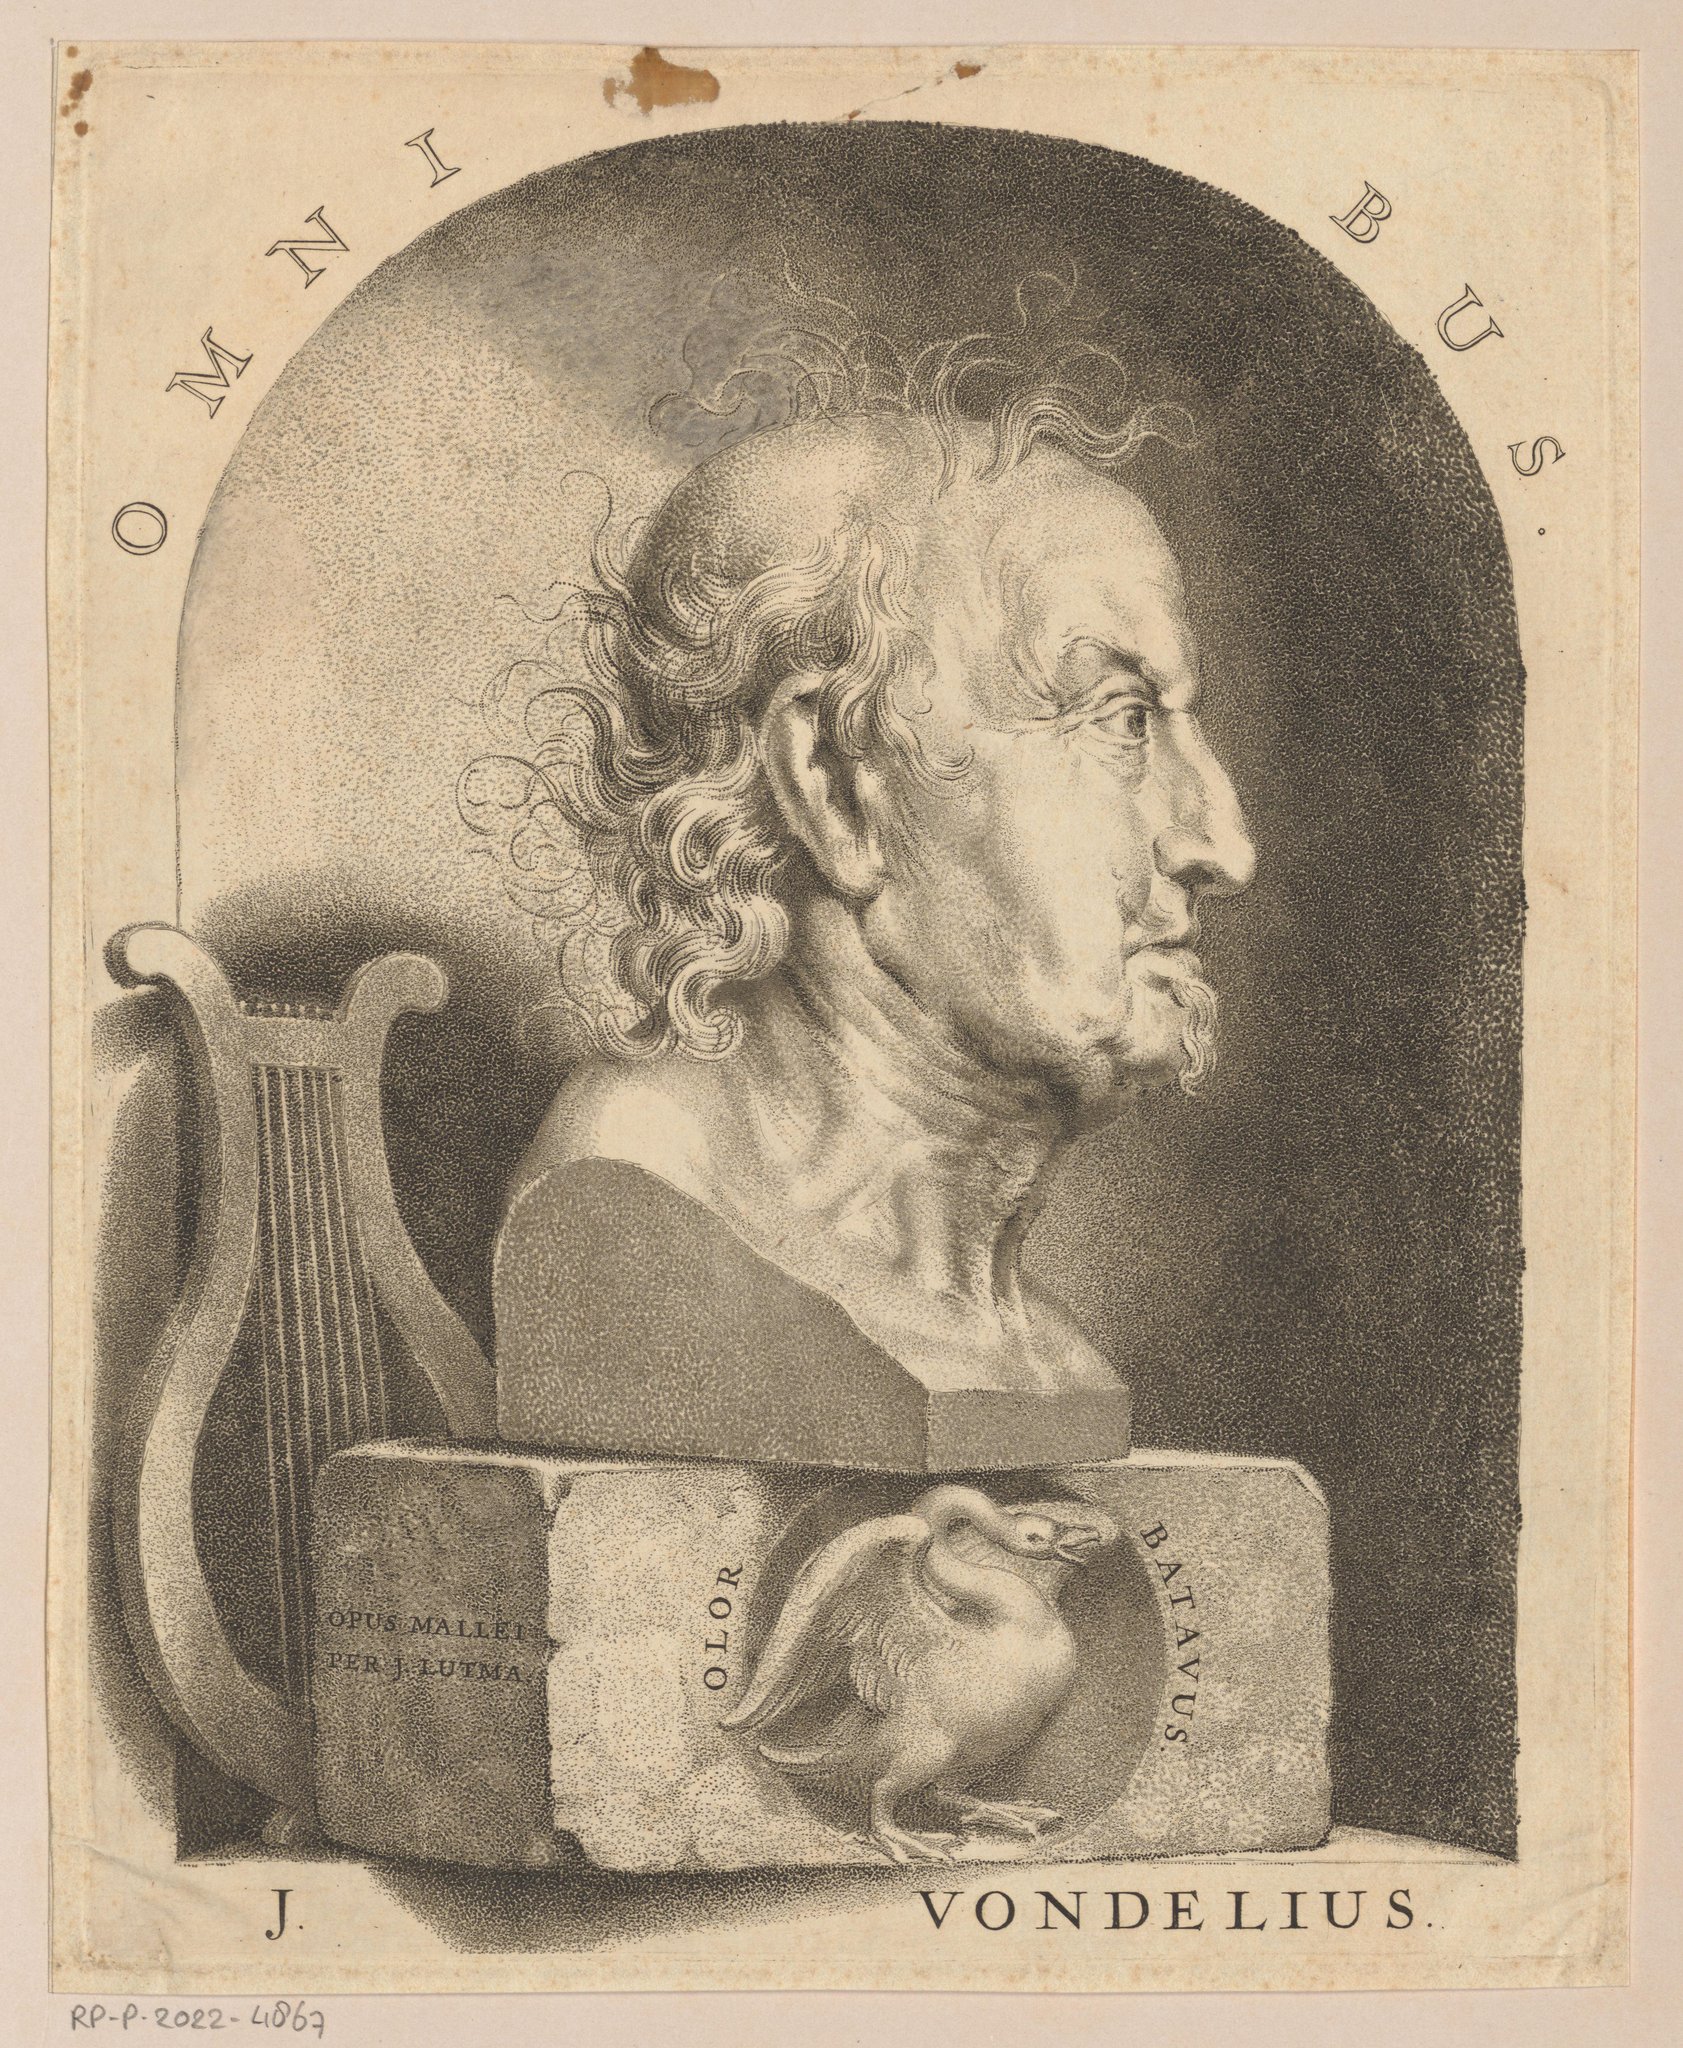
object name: print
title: Portret van Joost van den Vondel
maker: johannes lutma (1624-1689)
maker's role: print maker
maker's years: 1624-1689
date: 1681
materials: paper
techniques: punched engraving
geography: amsterdam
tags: amsterdam, joost van den vondel, historical persons, portrait of a writer, writer, poet, author, water-birds: swan - ff - fabulous animals (sometimes wrongly called 'grotesques'); 'mostri' (ripa)